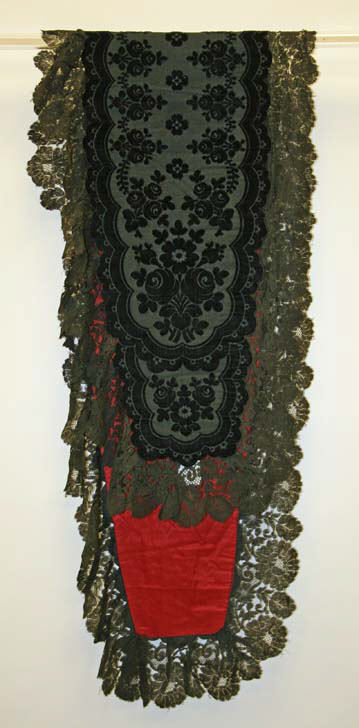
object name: mantilla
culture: spanish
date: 1834-1866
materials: silk